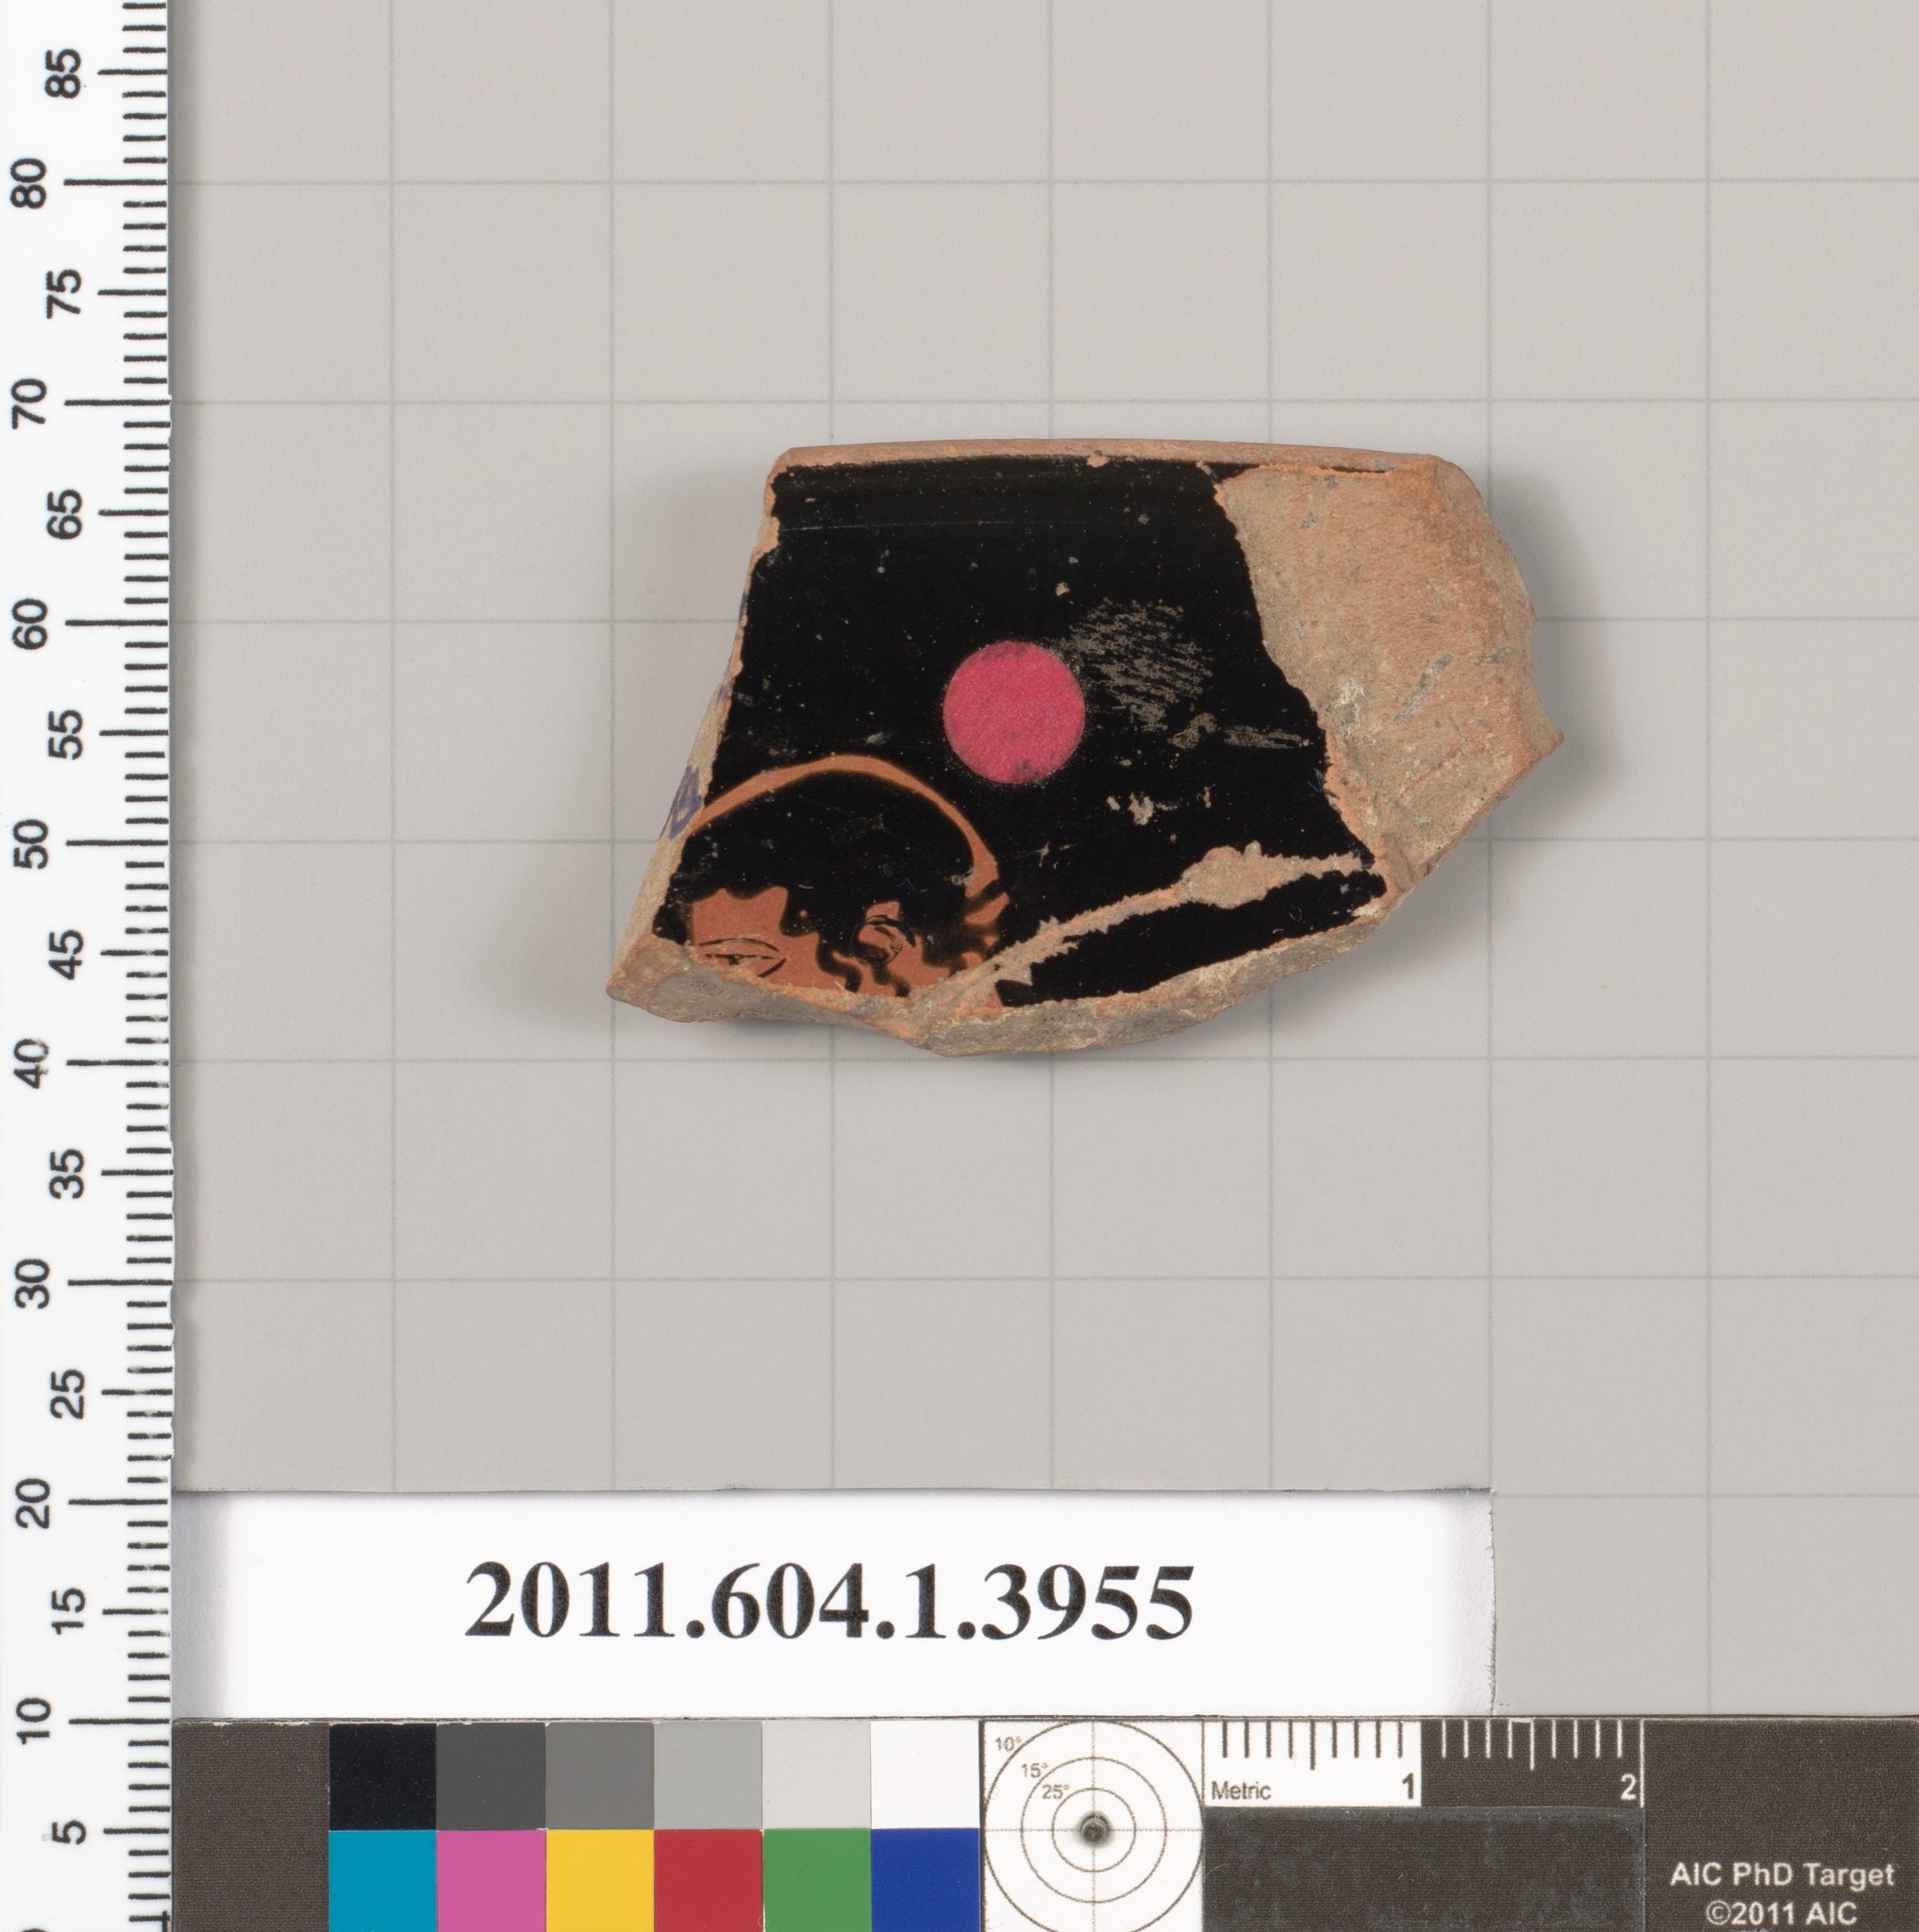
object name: kylix fragment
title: Terracotta rim fragment of a kylix (drinking cup)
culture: greek, attic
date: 475-451 BCE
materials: terracotta